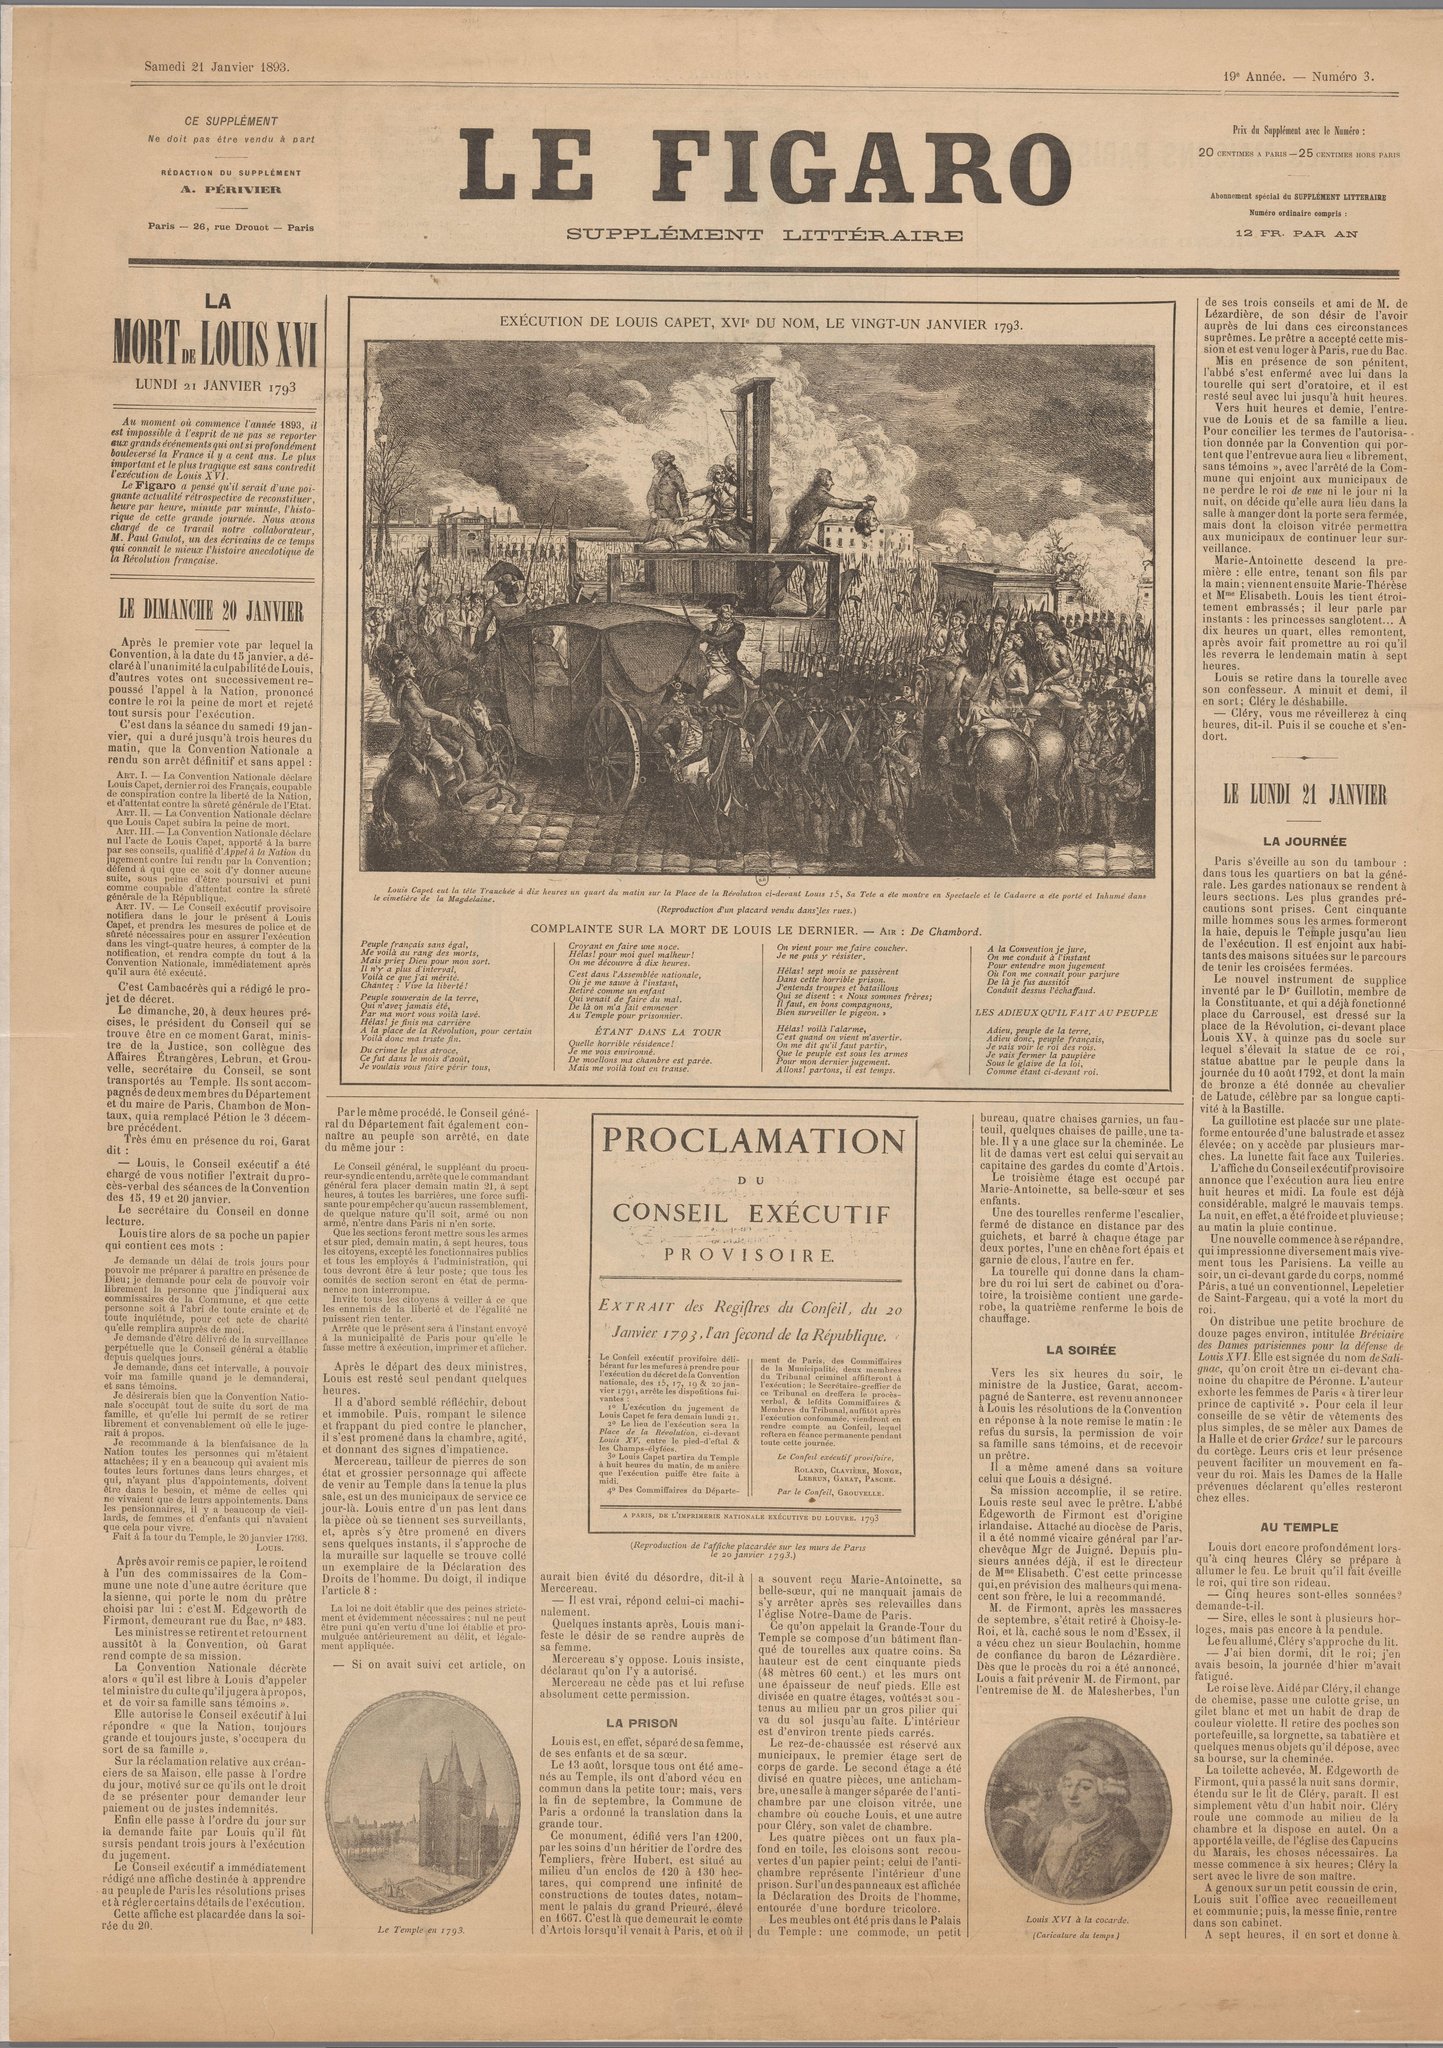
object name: newspaper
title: Le Figaro, 21 januari 1893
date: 1893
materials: paper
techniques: printing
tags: lodewijk xvi (koning van frankrijk), violent death ~ beheading by guillotine, on the scaffold or place of execution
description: Krant Le Figaros, van 21 januari 1893. 100-jarige herdenking van de terechtstelling van koning Lodewijk XVI op de Place de la Revolution, 21 januari 1793.